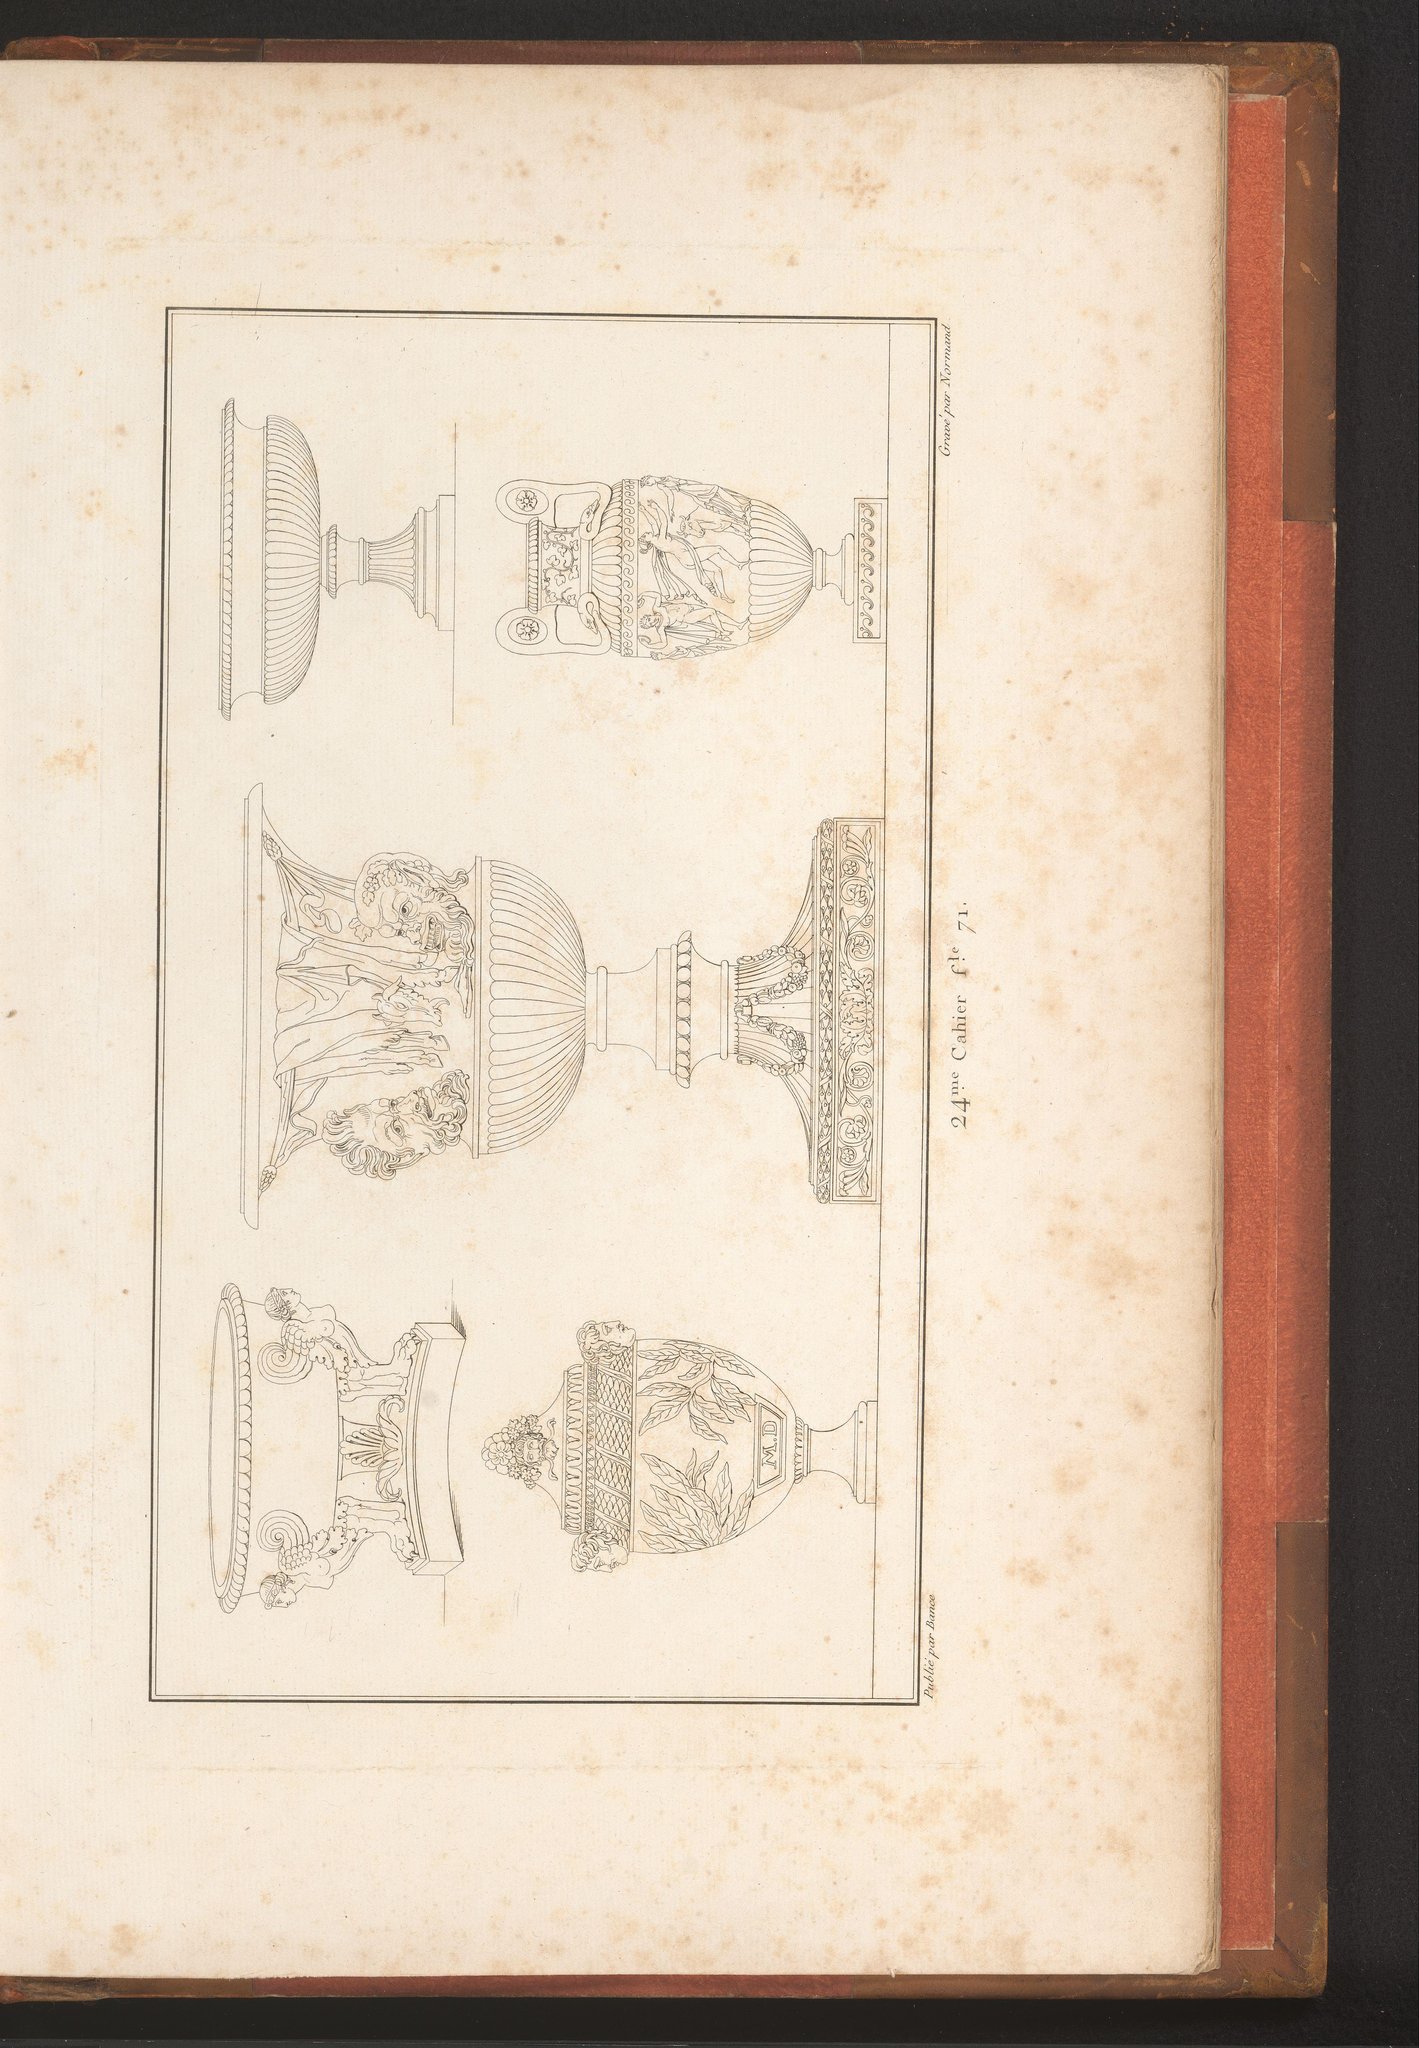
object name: ornament print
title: Vazen en schalen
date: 1820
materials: paper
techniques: etching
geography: paris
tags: vase ~ ornament, garden vase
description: Vazen en schalen. Onderdeel (24e. Cah.er f.le 71) van het prentalbum met twee series van in totaal 138 ornamentprenten door Beauvallet en Normand, 'Fragmens d'Ornemens dans le Style Antique'.